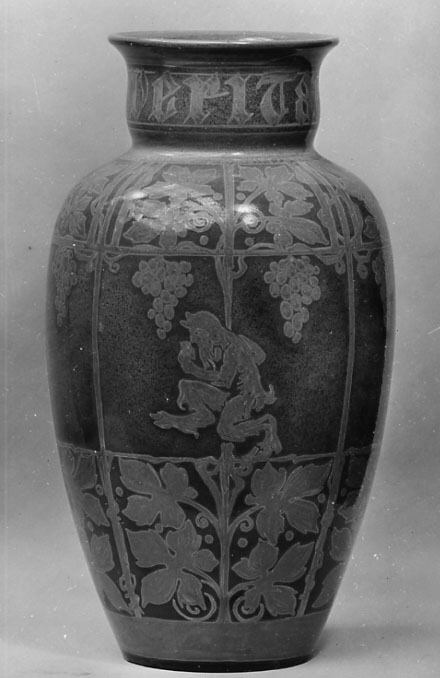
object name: vase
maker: g. m. forsyth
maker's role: designer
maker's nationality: british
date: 1900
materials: pottery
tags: grapes,pan